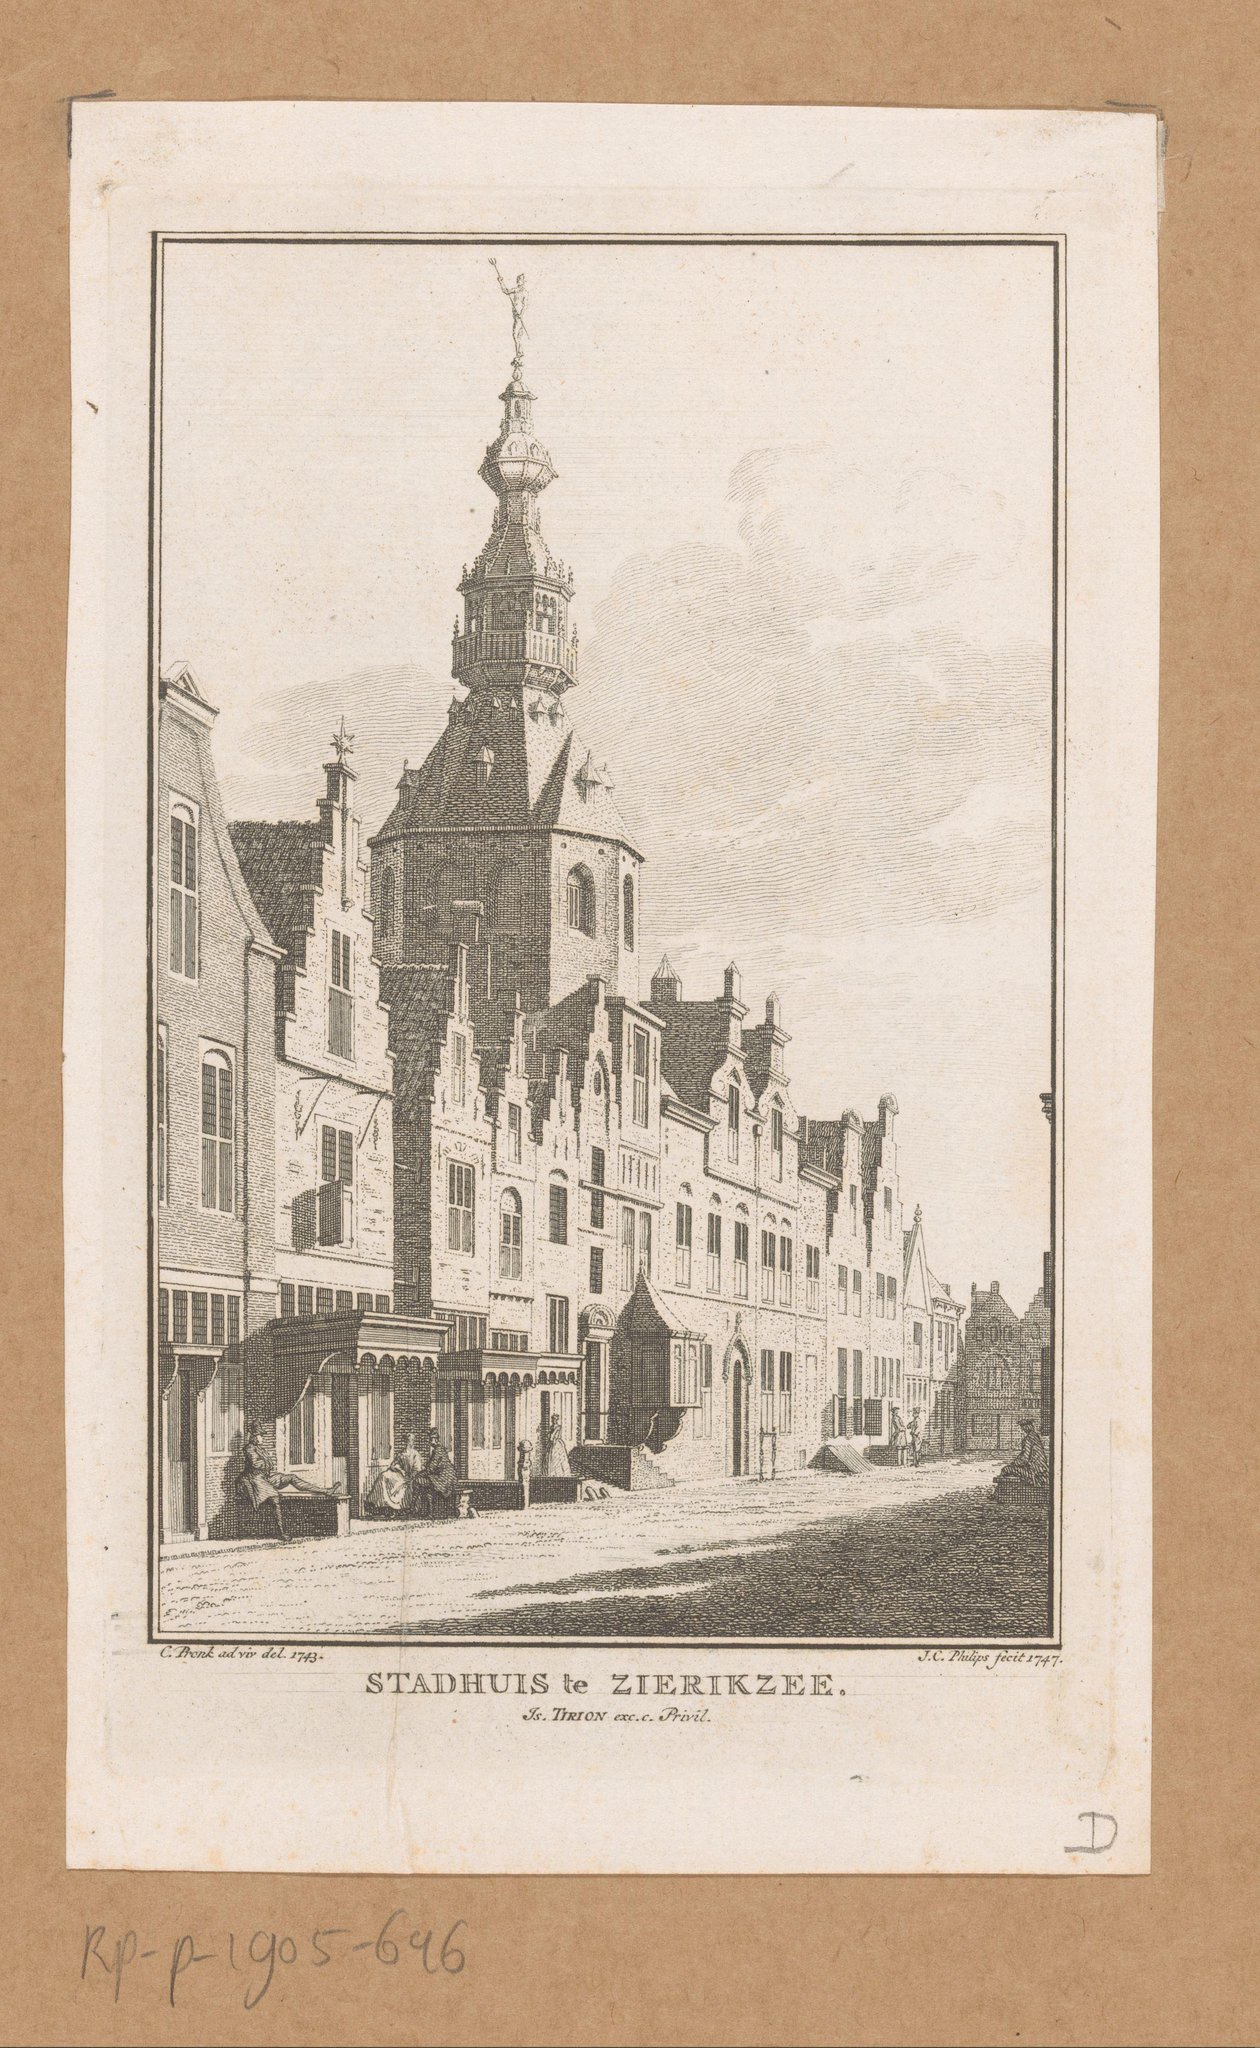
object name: book illustration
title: Gezicht op het stadhuis van Zierikzee, 1743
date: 1747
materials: paper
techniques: etching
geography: amsterdam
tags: townhall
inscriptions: collector's mark: Lugt 2228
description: Prent ook gebruikt in: Wagenaar, Jan. Tegenwoordige staat der Vereenigde Nederlanden (...). Amsterdam: Isaak Tirion, 1751, dl. 9, tussen p. 326 en 327. Zie RP-P-AO-15-23-1 voor proefdruk.